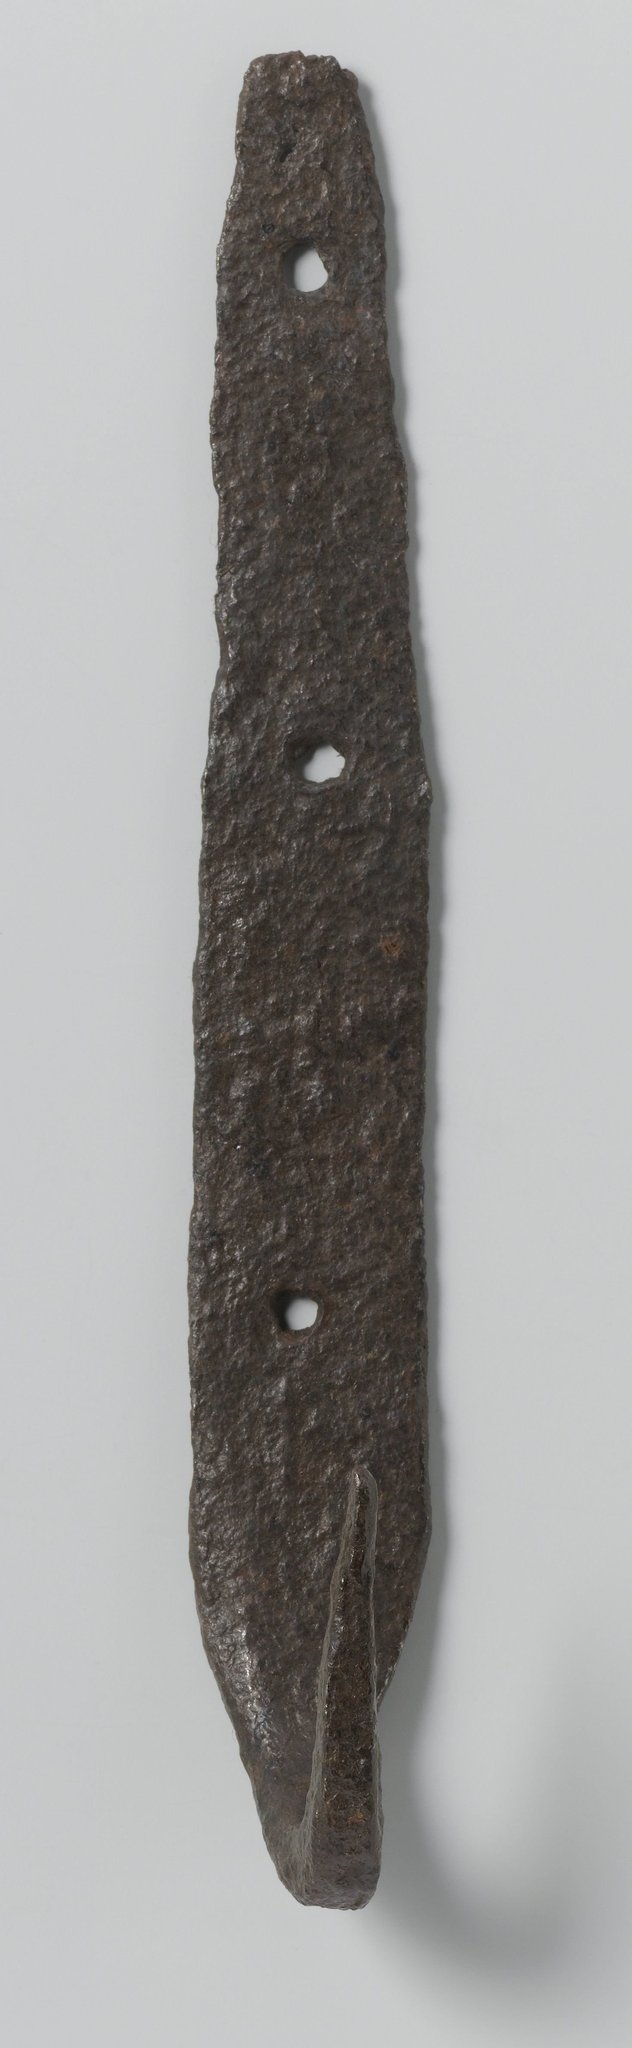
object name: hook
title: Haak, plat met drie spijkergaten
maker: Anonymous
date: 1590-1596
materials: iron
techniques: forging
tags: willem barendsz., amsterdam, jacob van heemskerck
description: Haak, plat van vorm met drie spijkergaten.